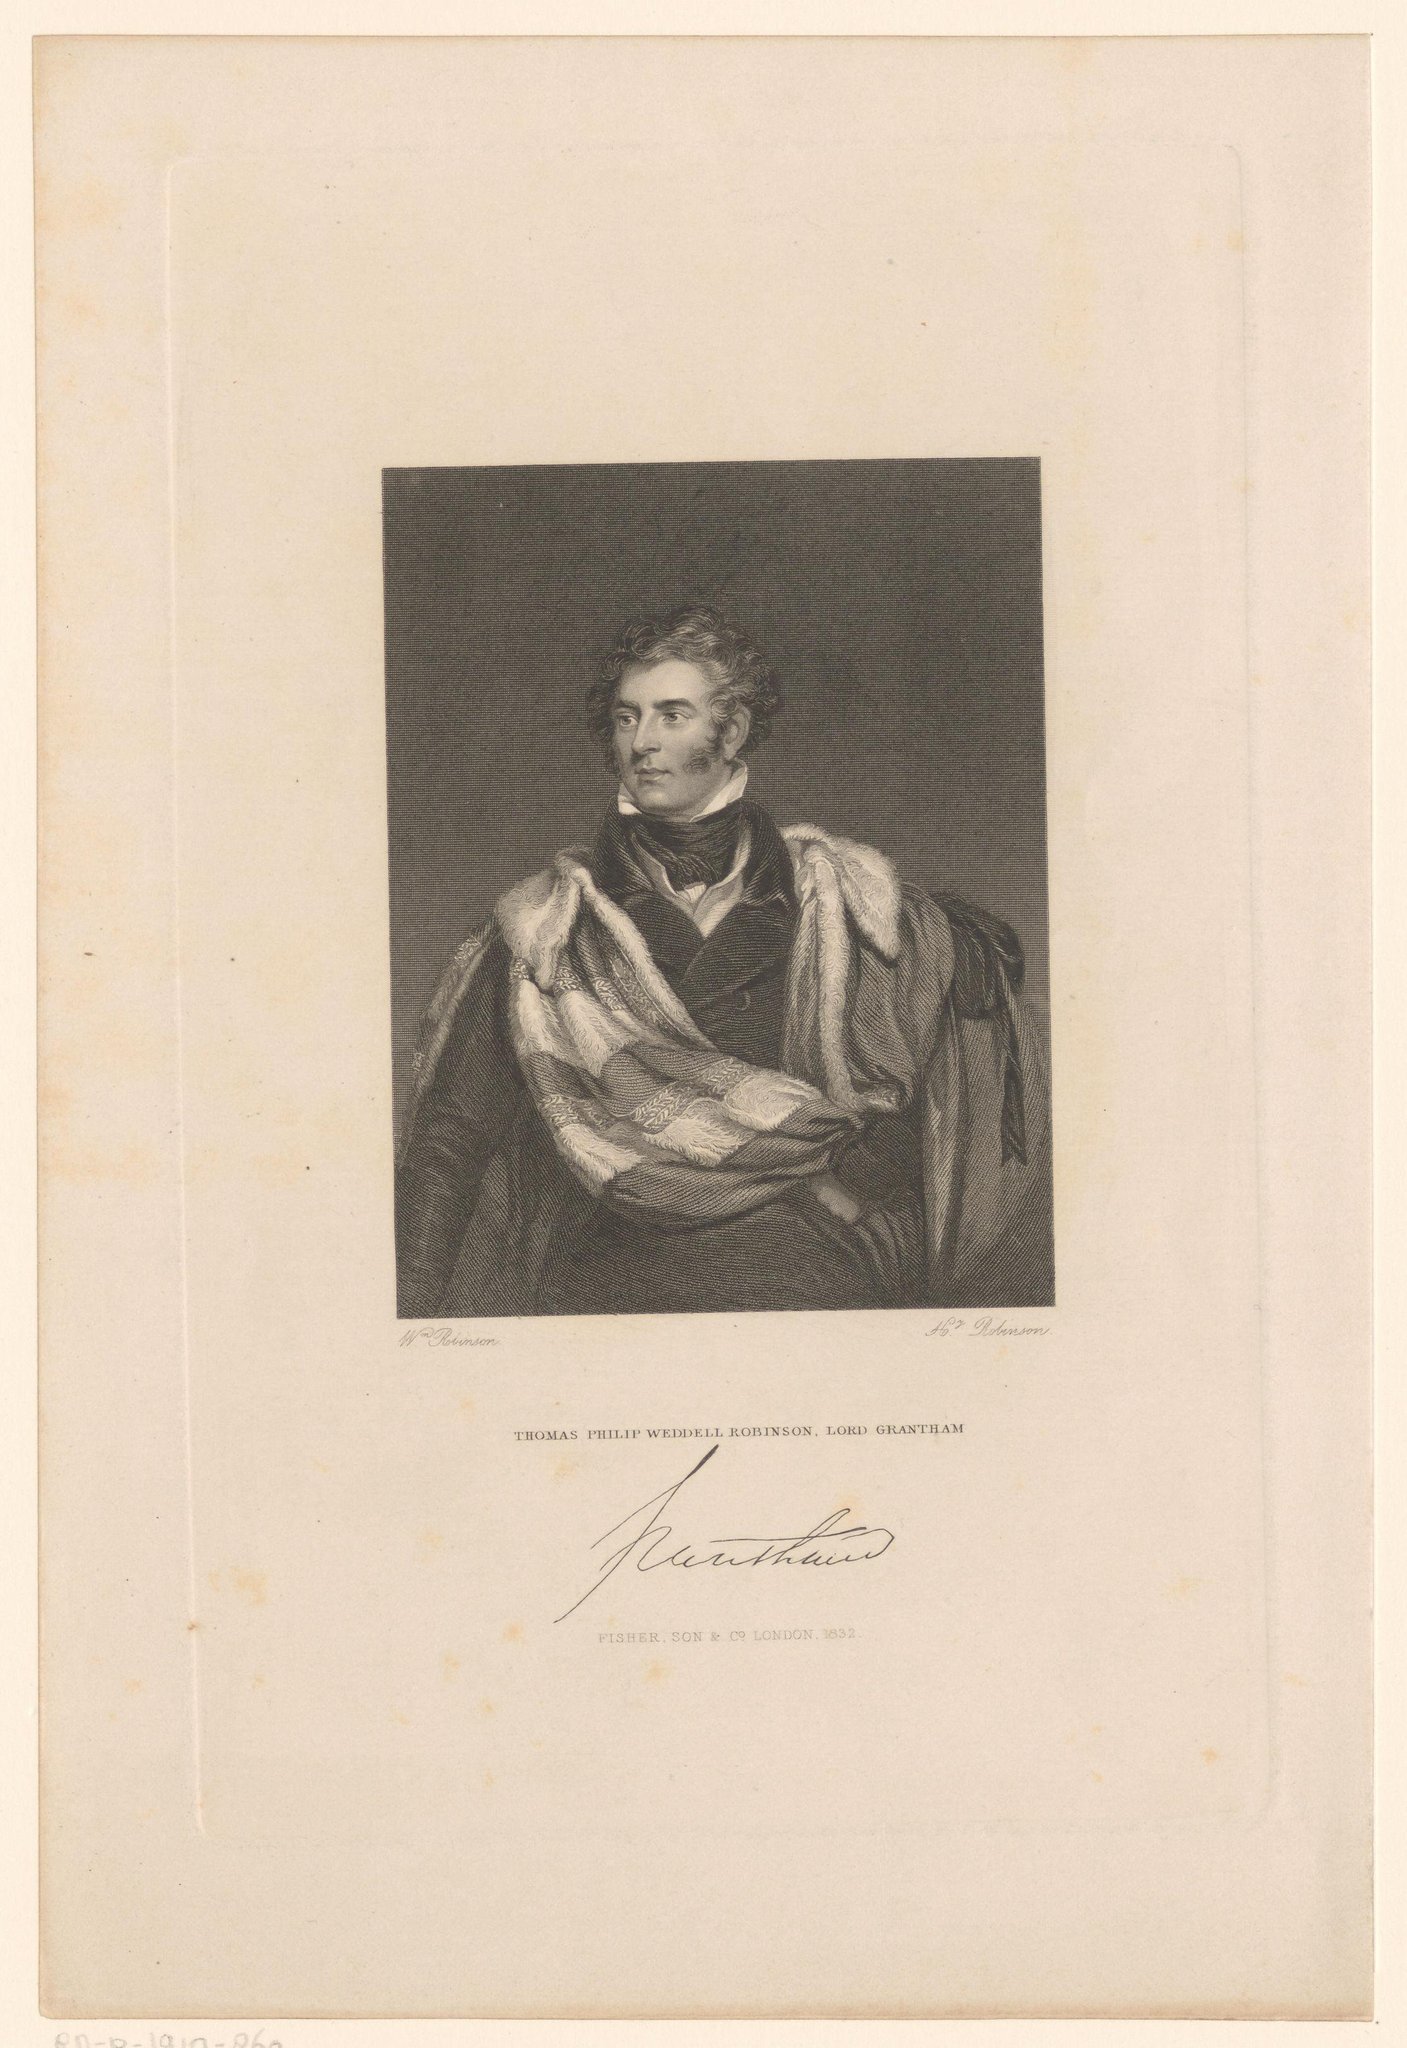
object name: print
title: Portret van Thomas de Grey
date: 1832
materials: paper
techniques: etching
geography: london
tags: historical persons, politician, e.g. party leader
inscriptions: collector's mark: Lugt 2228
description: Een facsimile signatuur in de ondermarge. Geportretteerde ook bekend onder de naam: Thomas Philip Weddell Robinson, Lord Grantham.